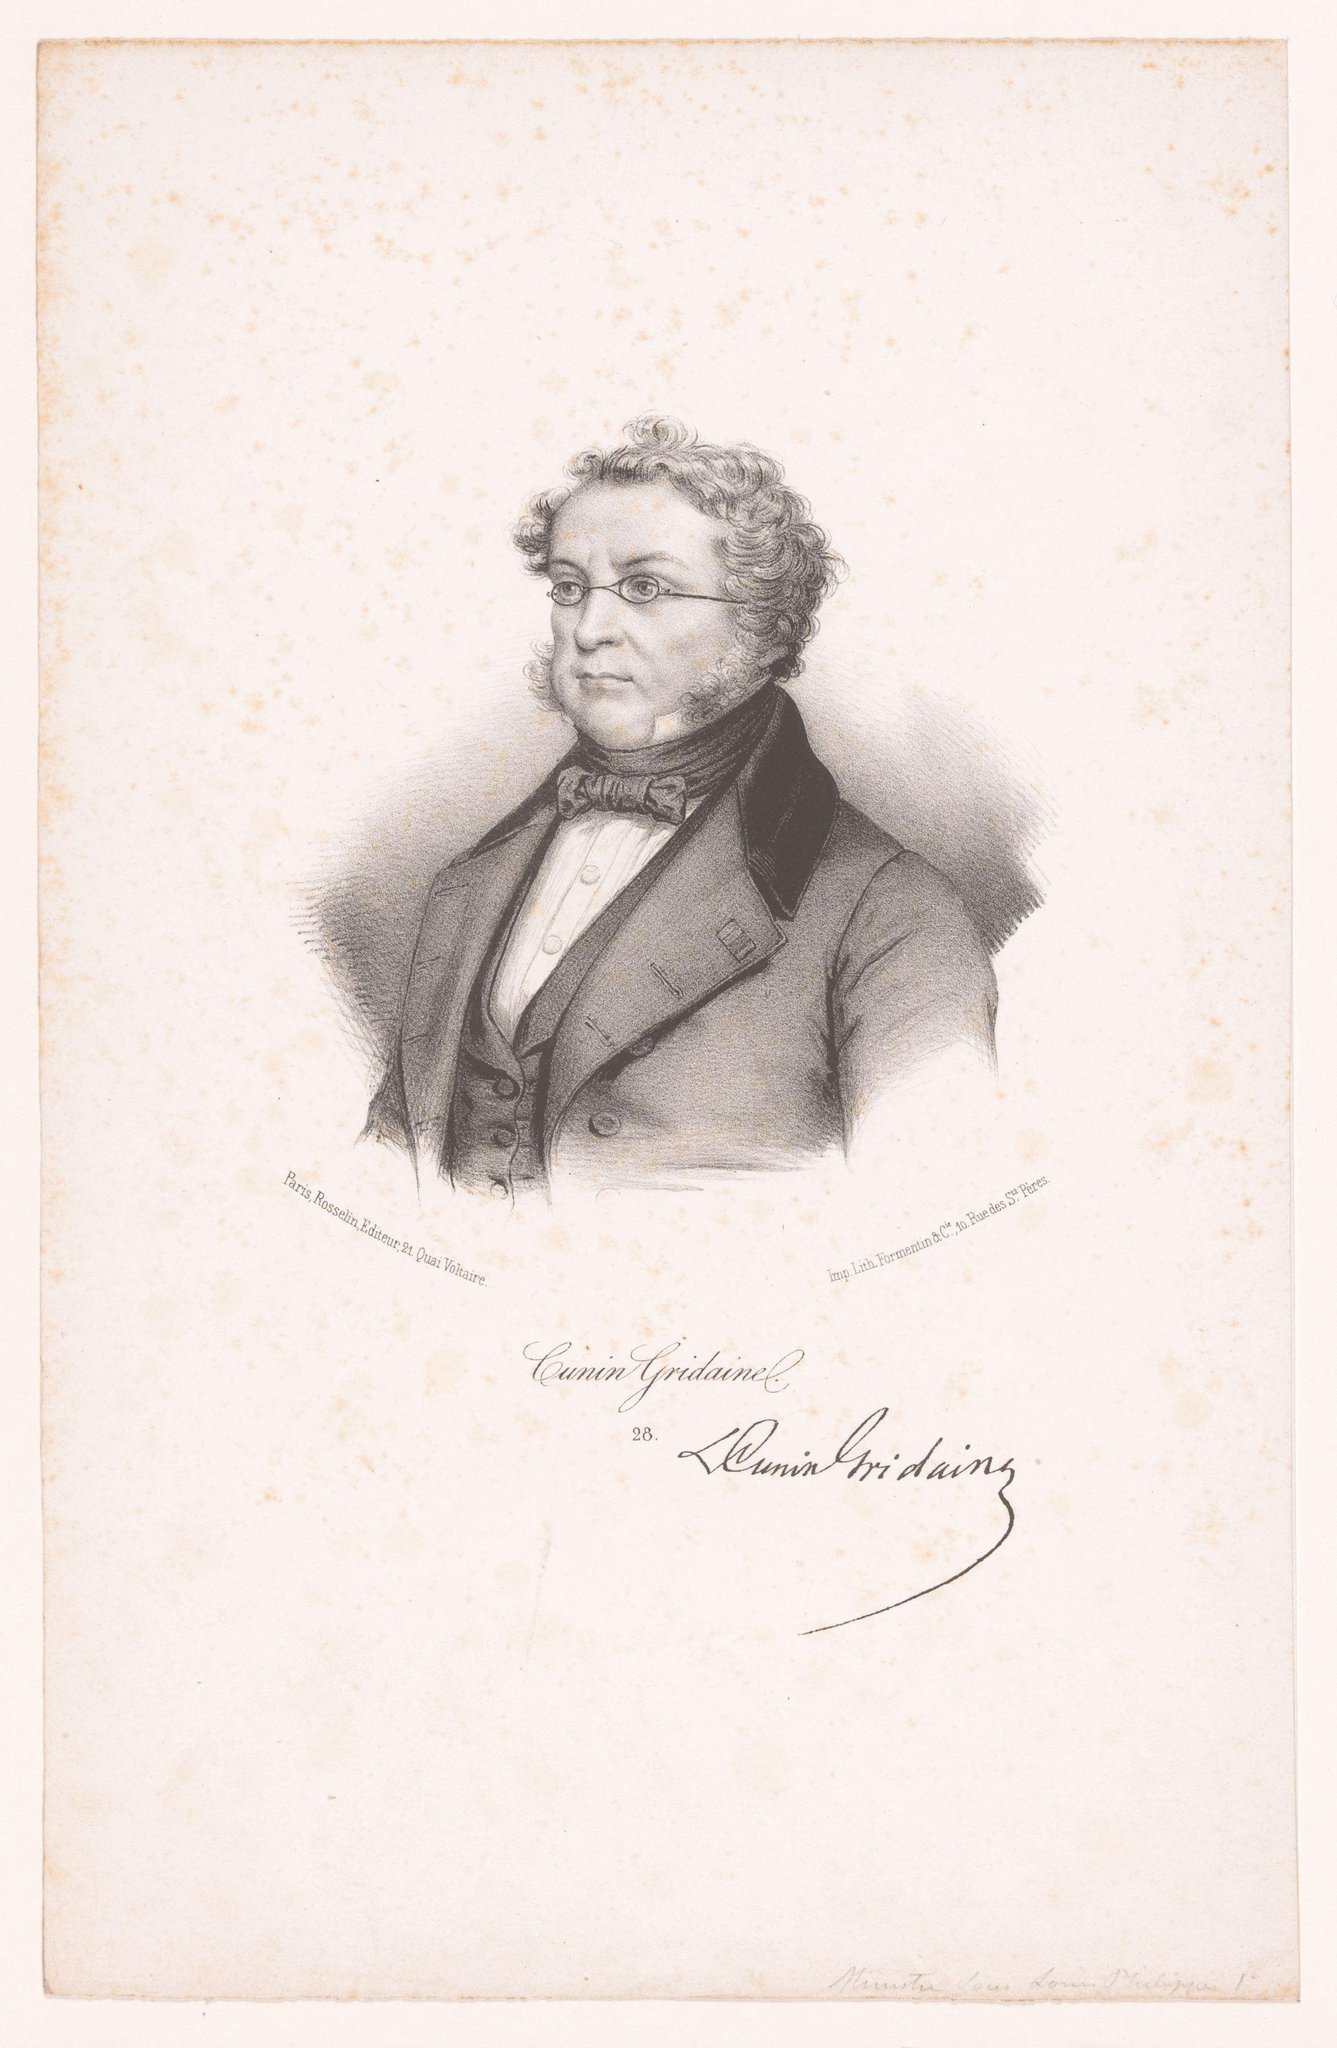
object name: print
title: Portret van Laurent Cunin-Gridaine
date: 1830-1856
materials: paper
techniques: lithograph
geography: paris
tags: politician, historical persons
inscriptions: collector's mark: Lugt 2228a